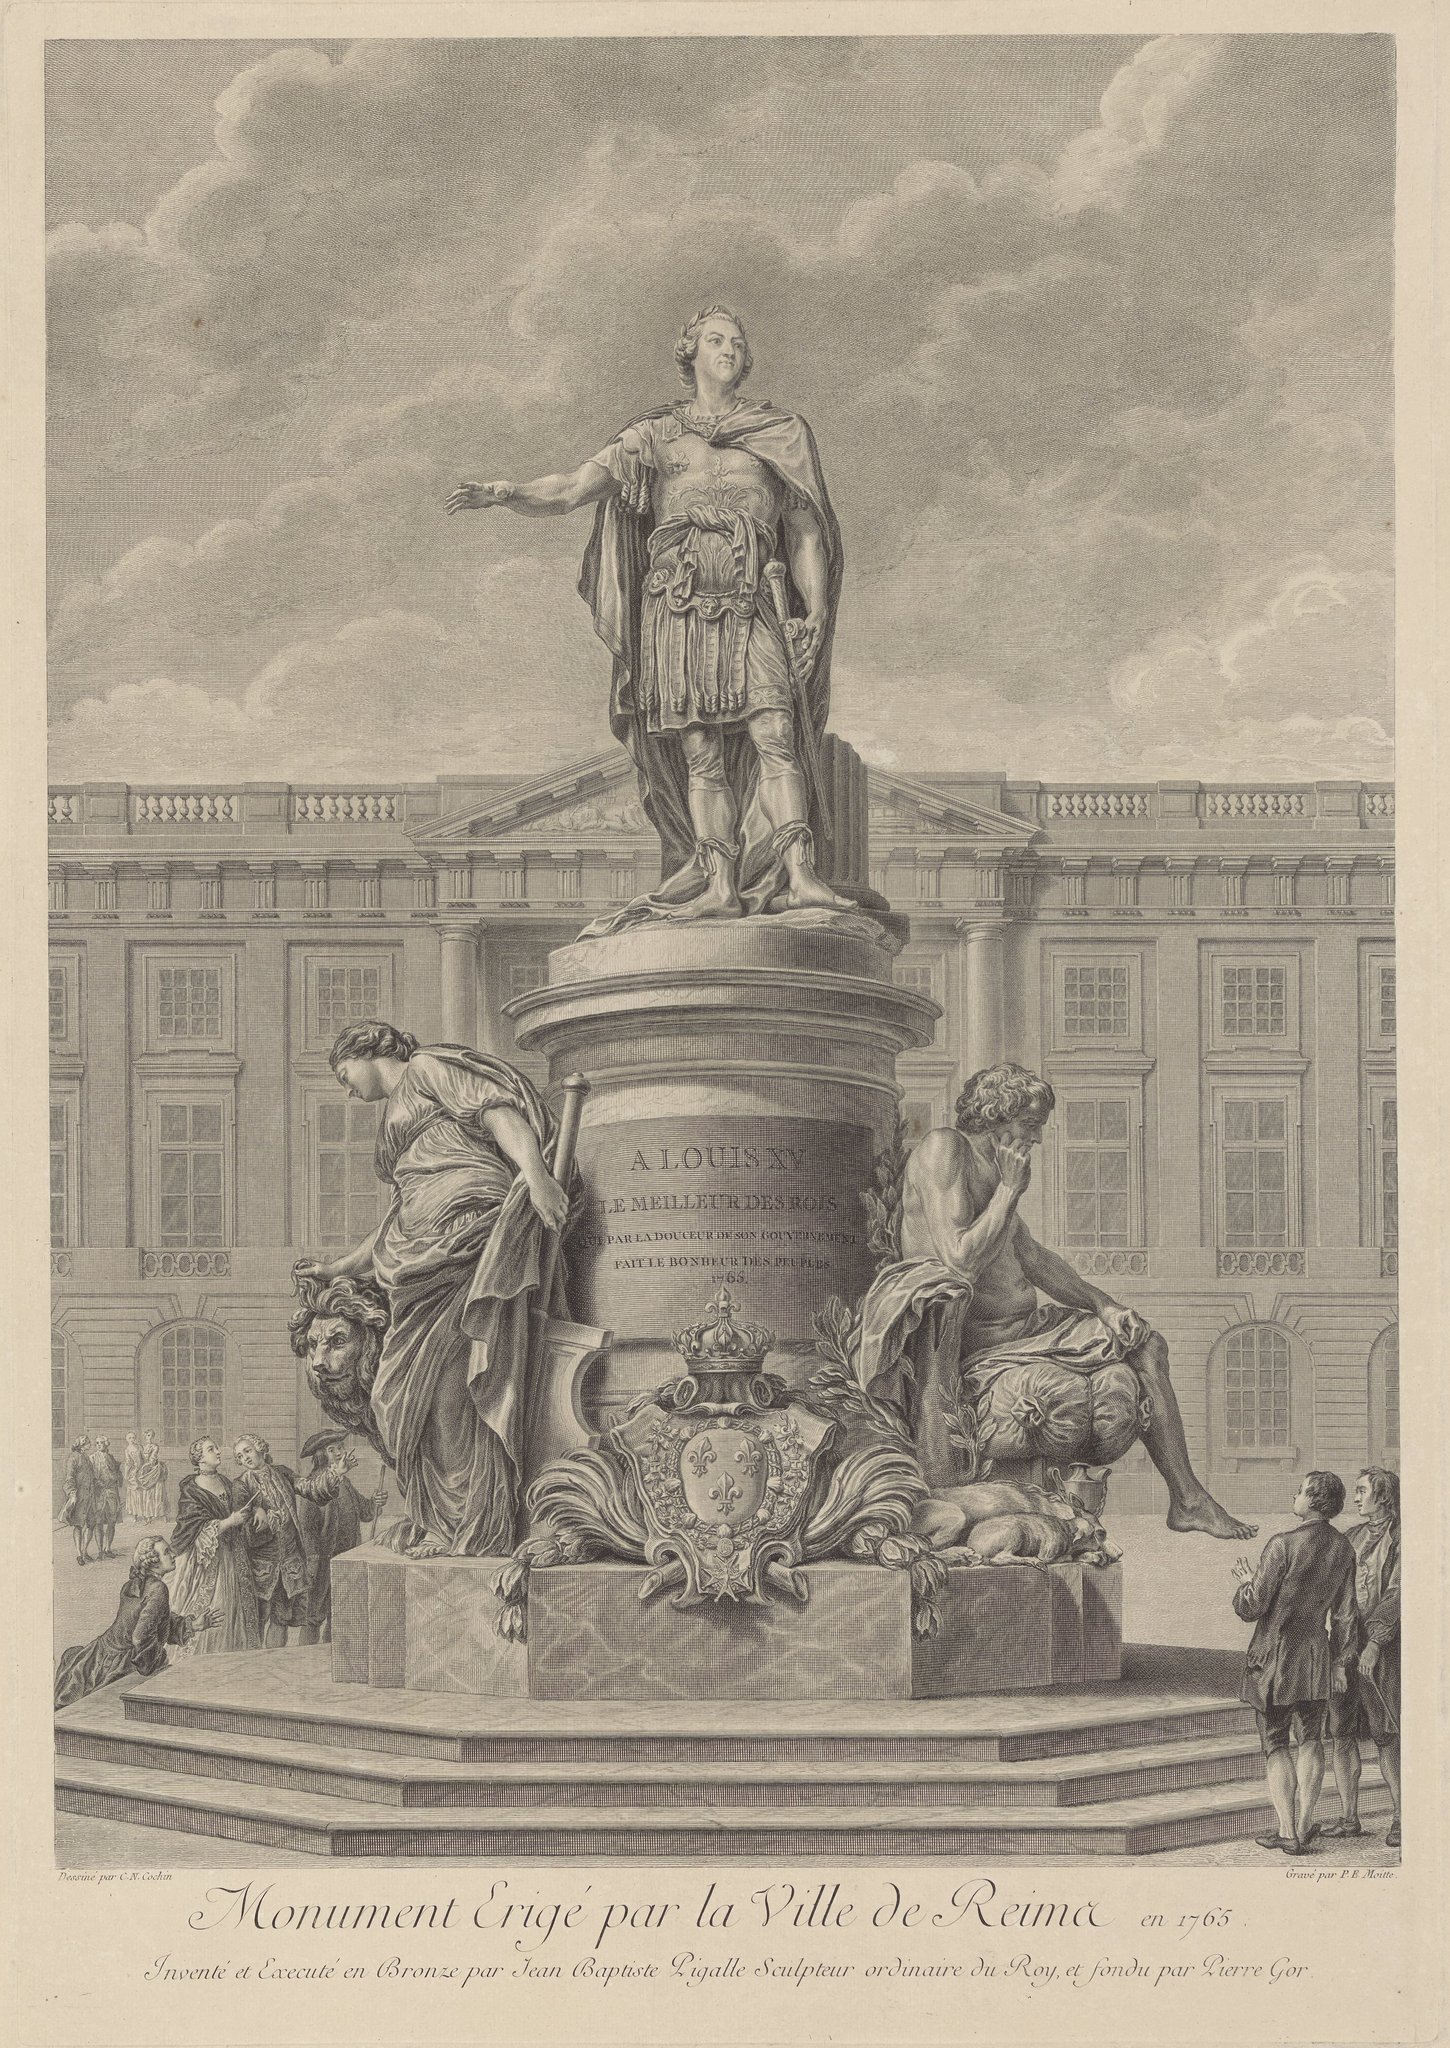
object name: print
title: Monument erigé par la ville de Reims en 1765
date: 1765-1780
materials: paper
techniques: engraving, etching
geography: france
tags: louis xv of france, historical persons, monument, statue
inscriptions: collector's mark: Lugt 2228